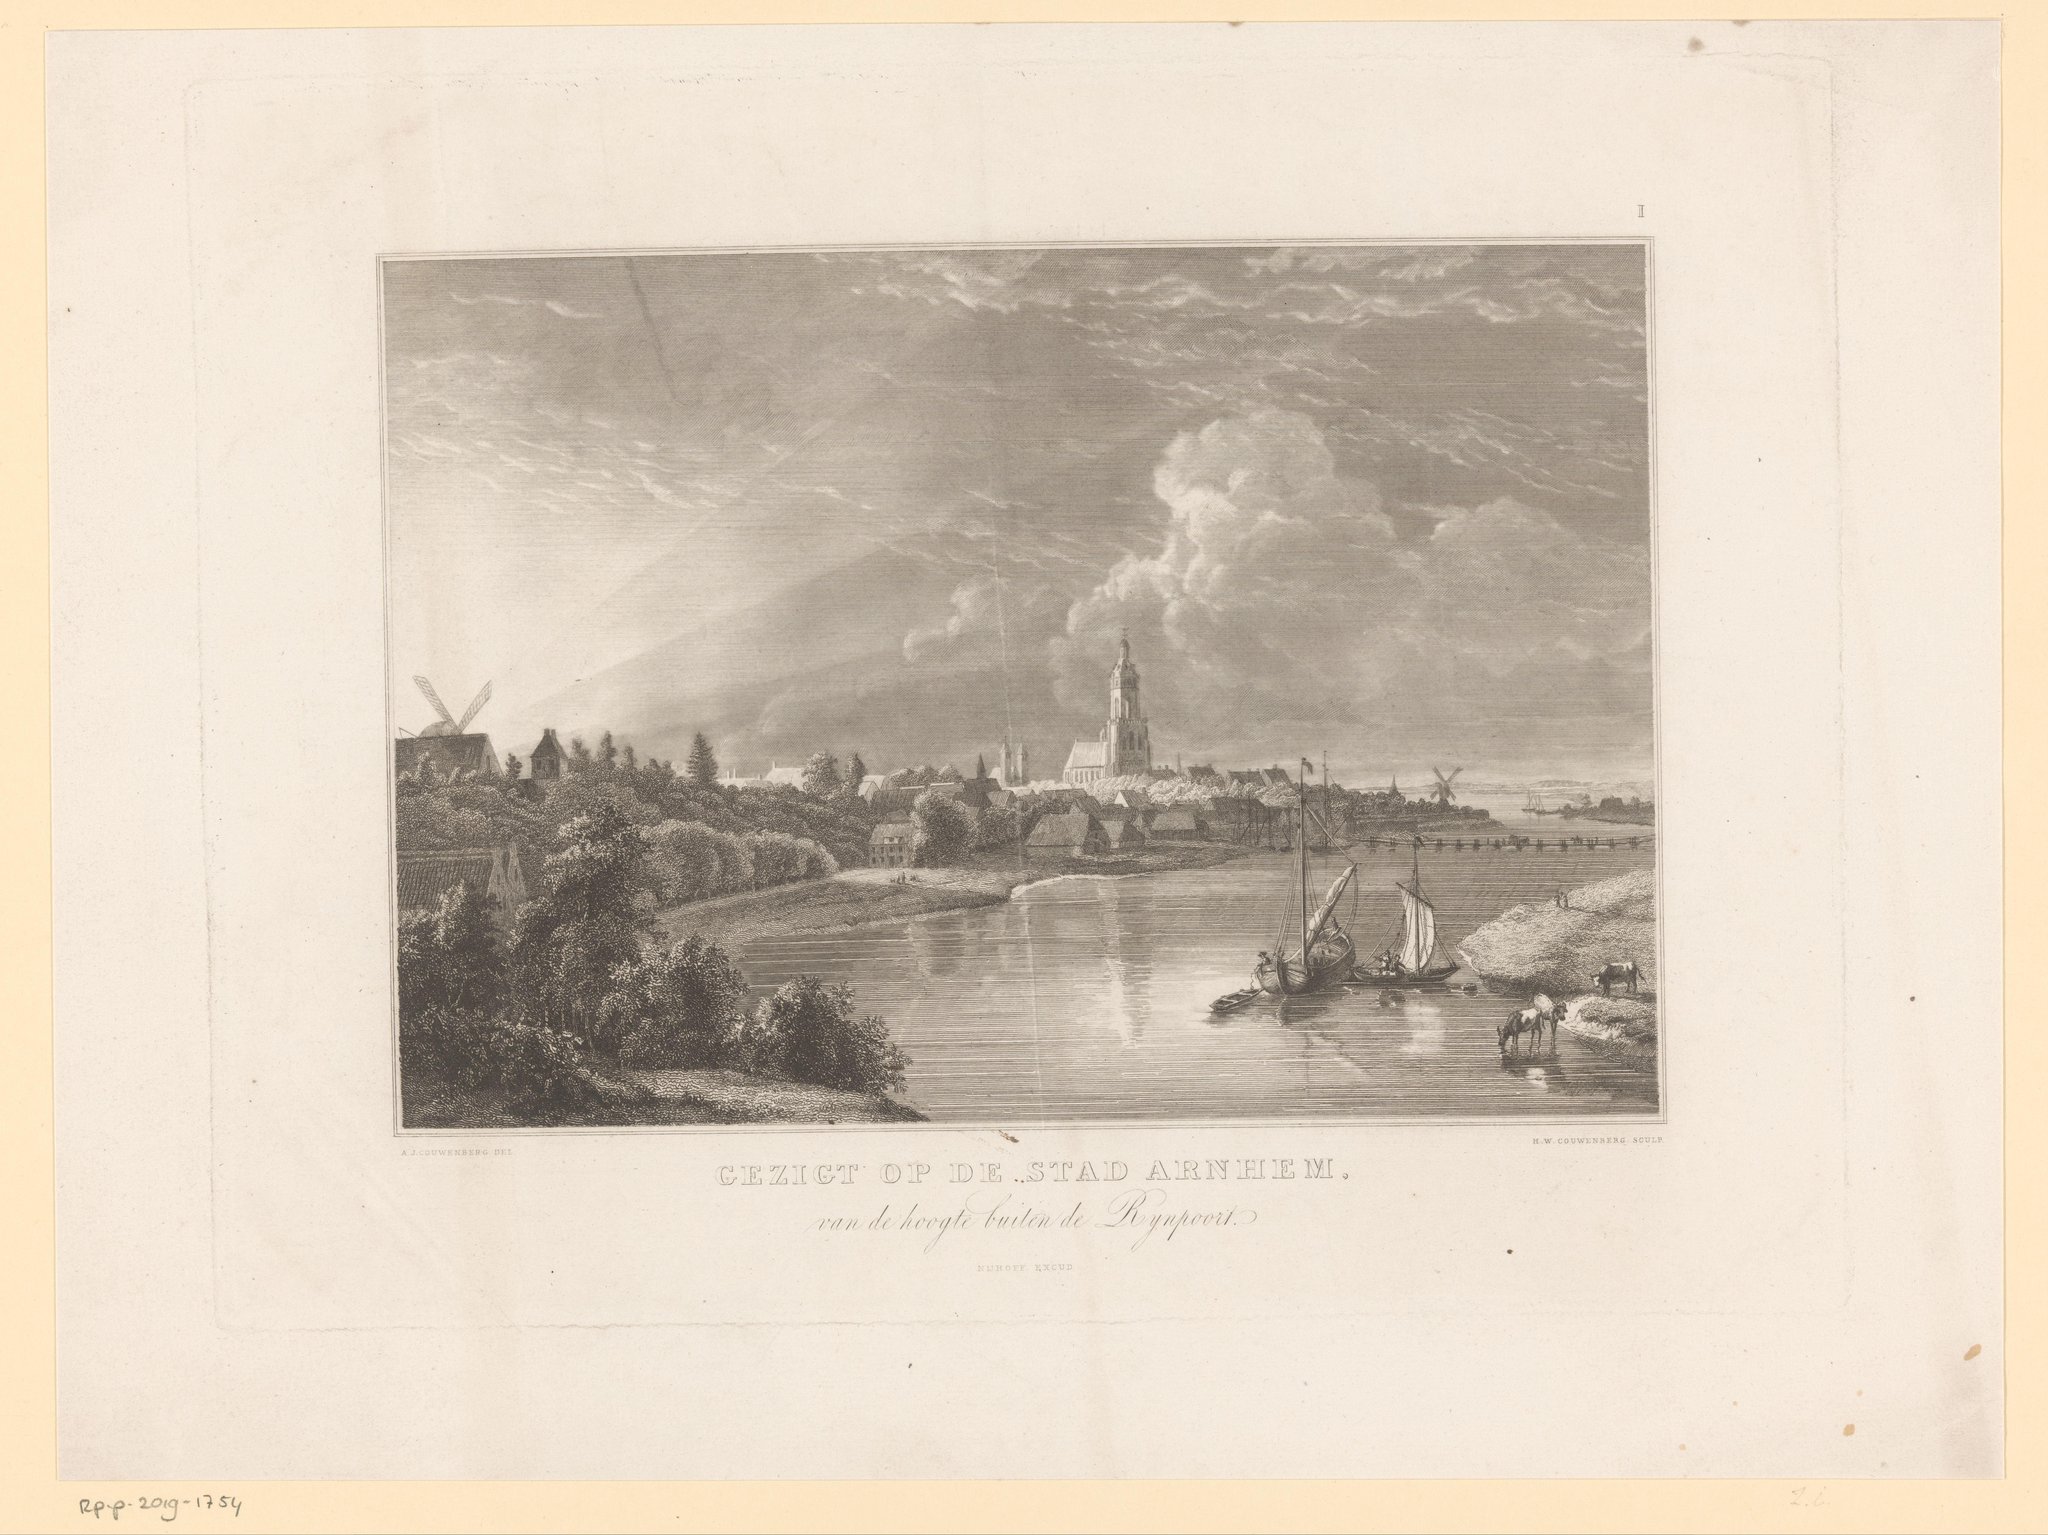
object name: print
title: Gezigt op de stad Arnhem van de hoogte buiten de Rijnpoort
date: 1824-1863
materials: paper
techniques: engraving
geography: arnhem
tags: city-view, and landscape with man-made constructions, arnhem